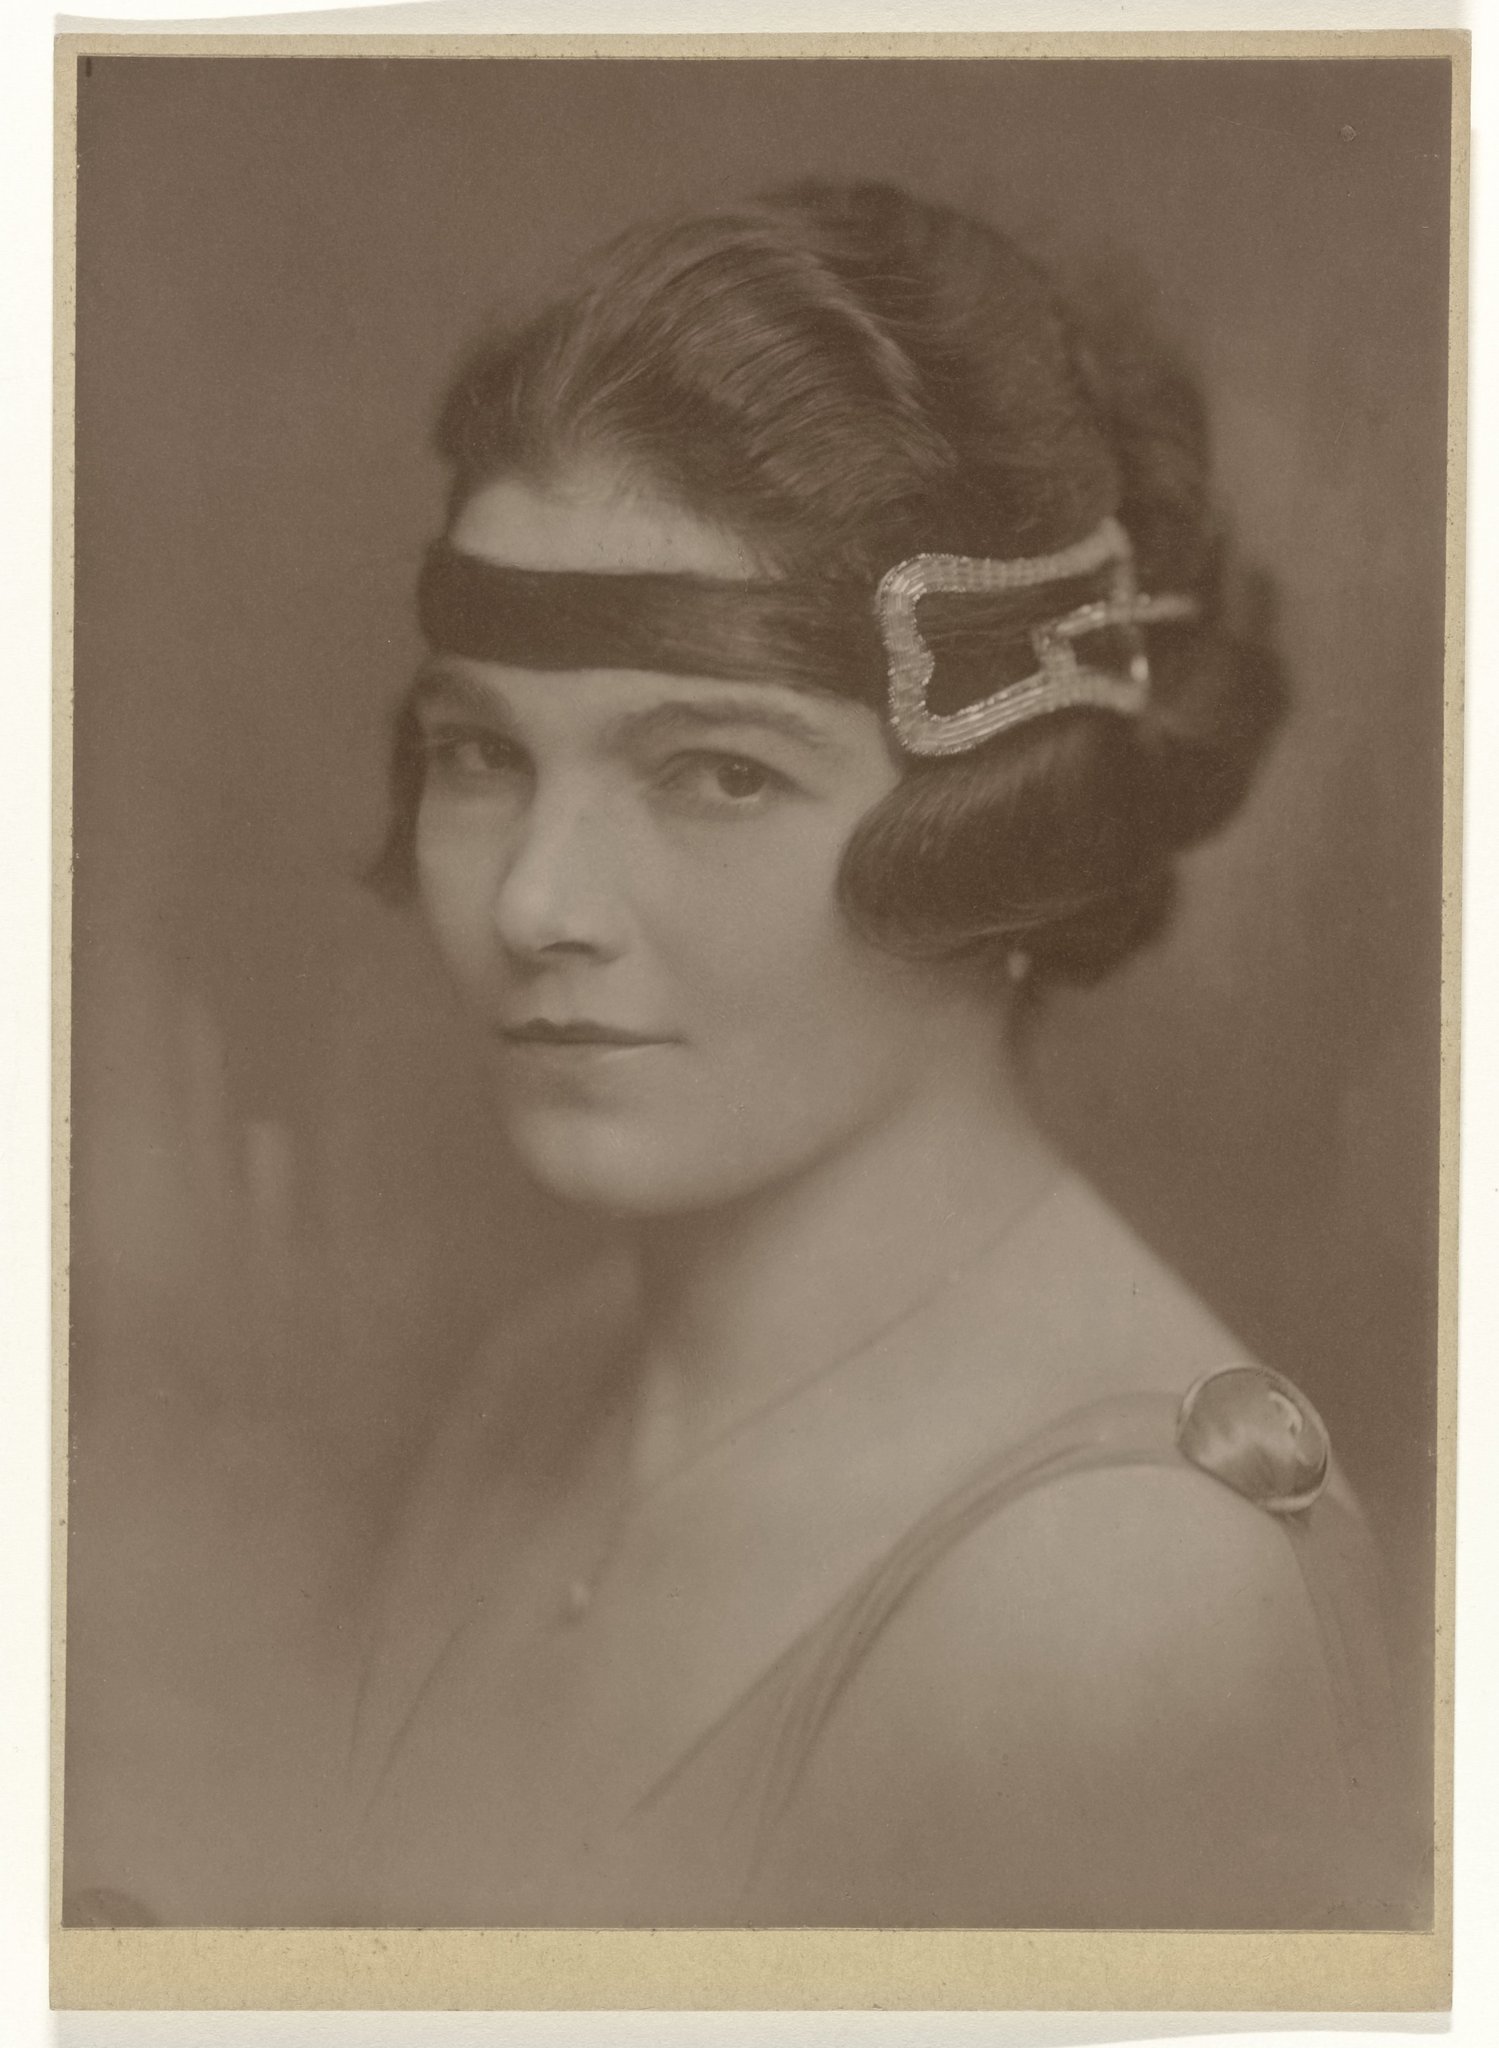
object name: photograph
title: Model met kapsel van kapper Maurice van Steen, Amsterdam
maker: jacob merkelbach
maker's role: fotograaf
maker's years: 1877-1942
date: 1915-1930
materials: cardboard, paper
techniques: carbon print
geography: amsterdam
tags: advertising